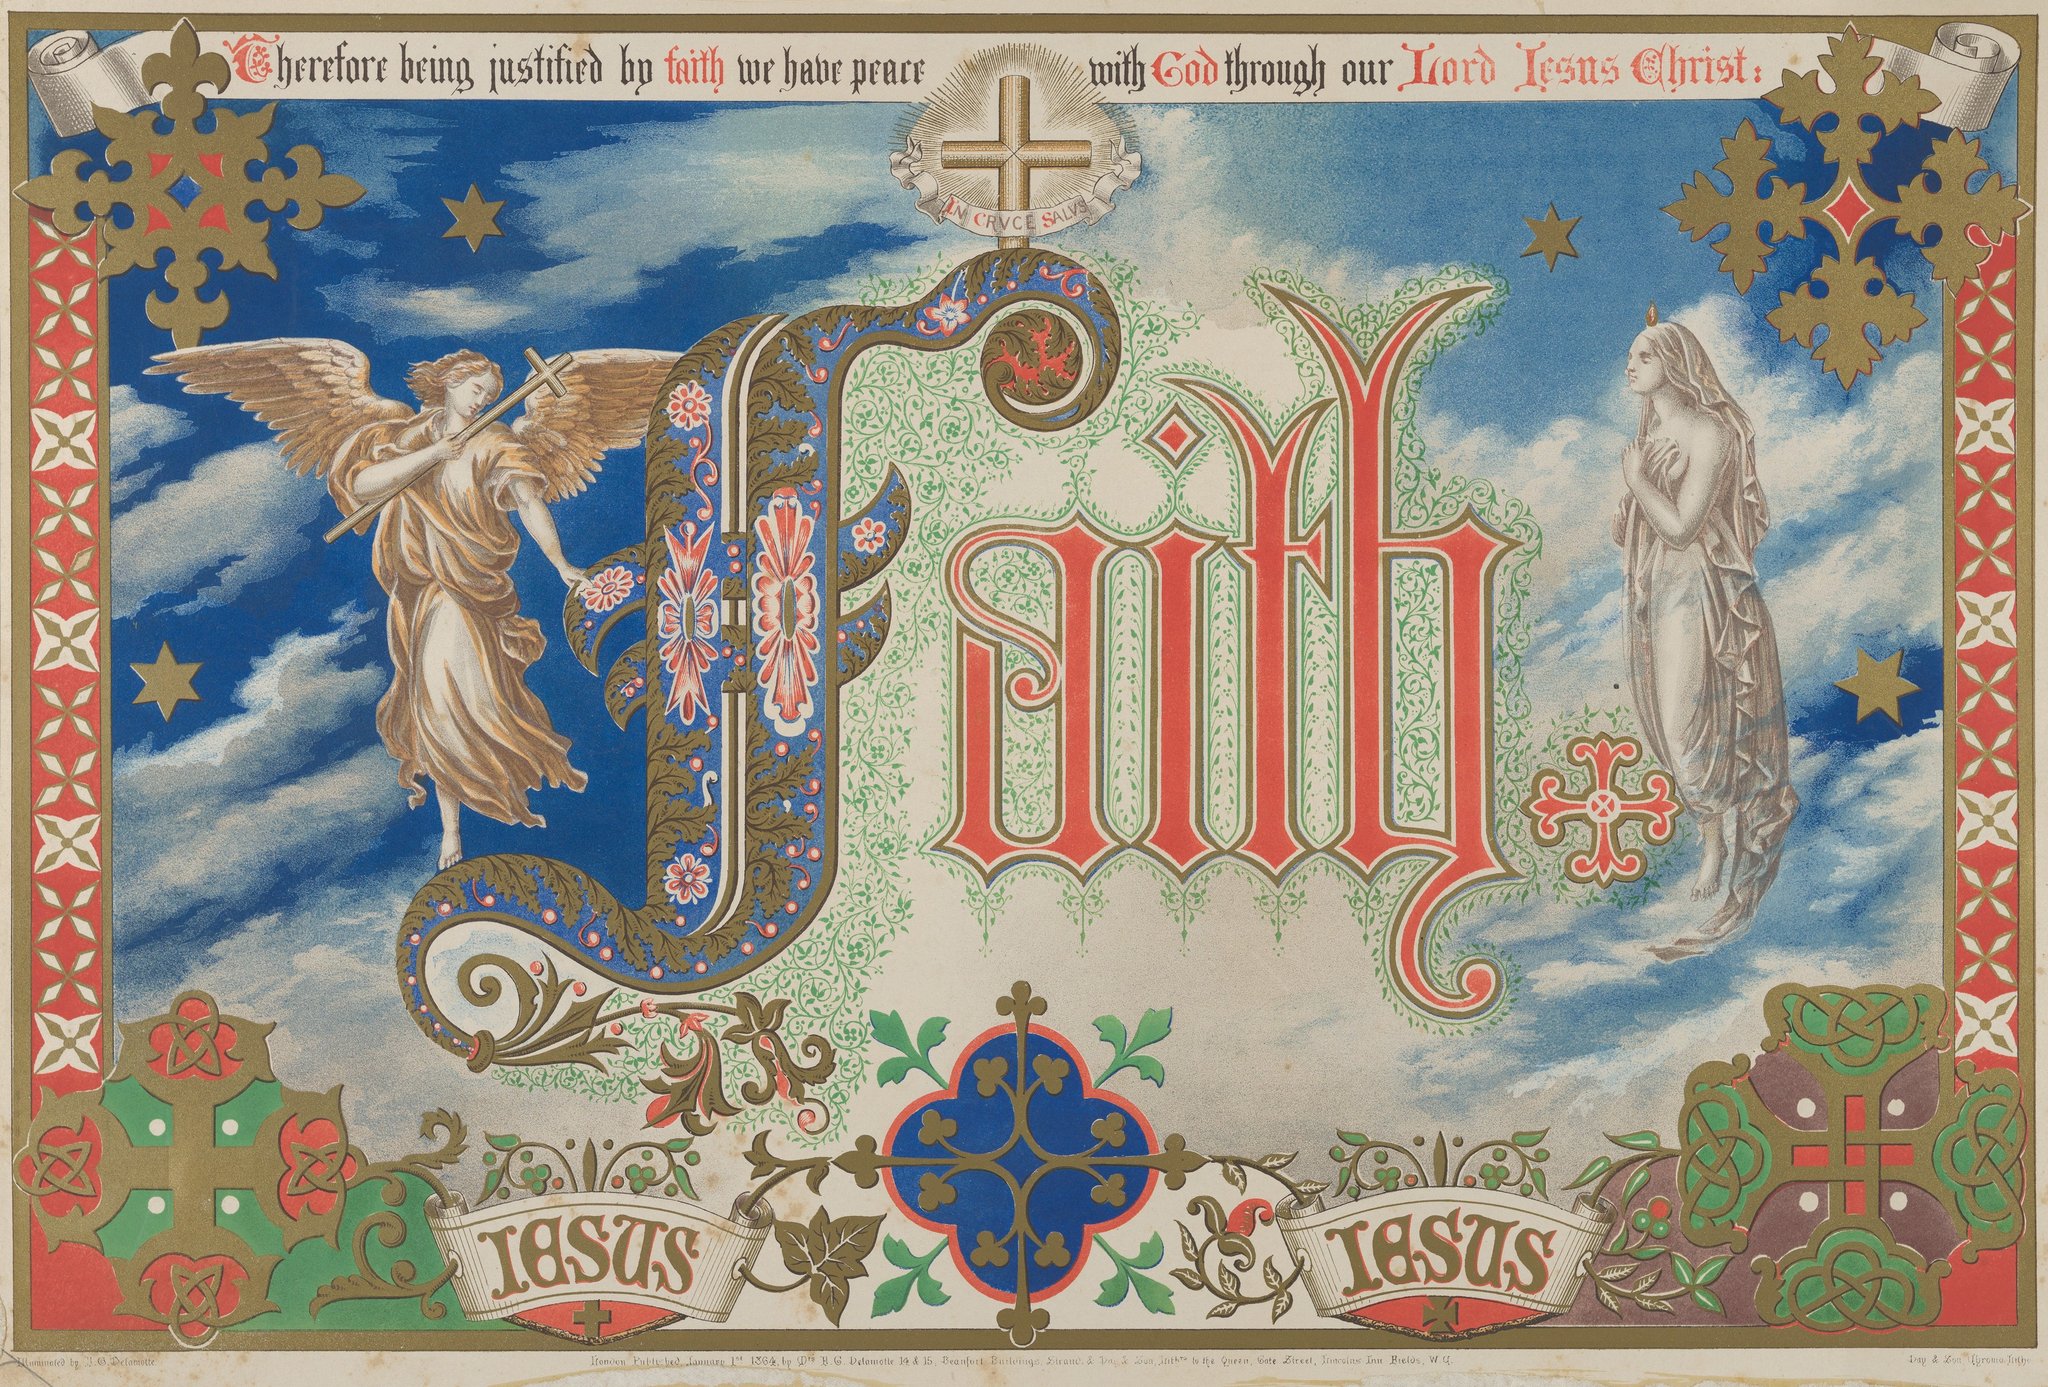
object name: print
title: Faith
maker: freeman gage delamotte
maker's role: artist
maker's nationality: british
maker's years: 1813-1862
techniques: lithograph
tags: angels,cross,jesus